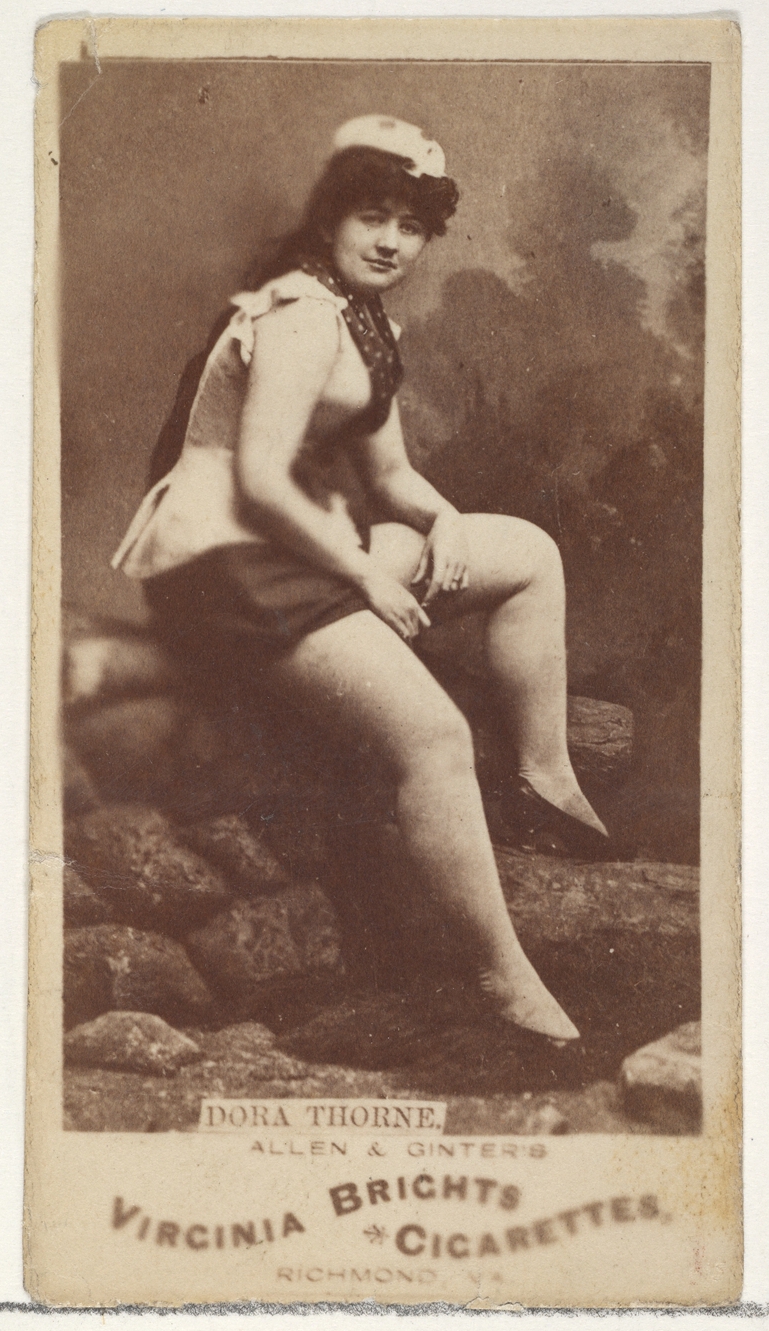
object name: photograph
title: Dora Thorne, from the Actors and Actresses series (N45, Type 1) for Virginia Brights Cigarettes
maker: allen & ginter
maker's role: publisher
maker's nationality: american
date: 1888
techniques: albumen silver print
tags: portraits,women,actresses